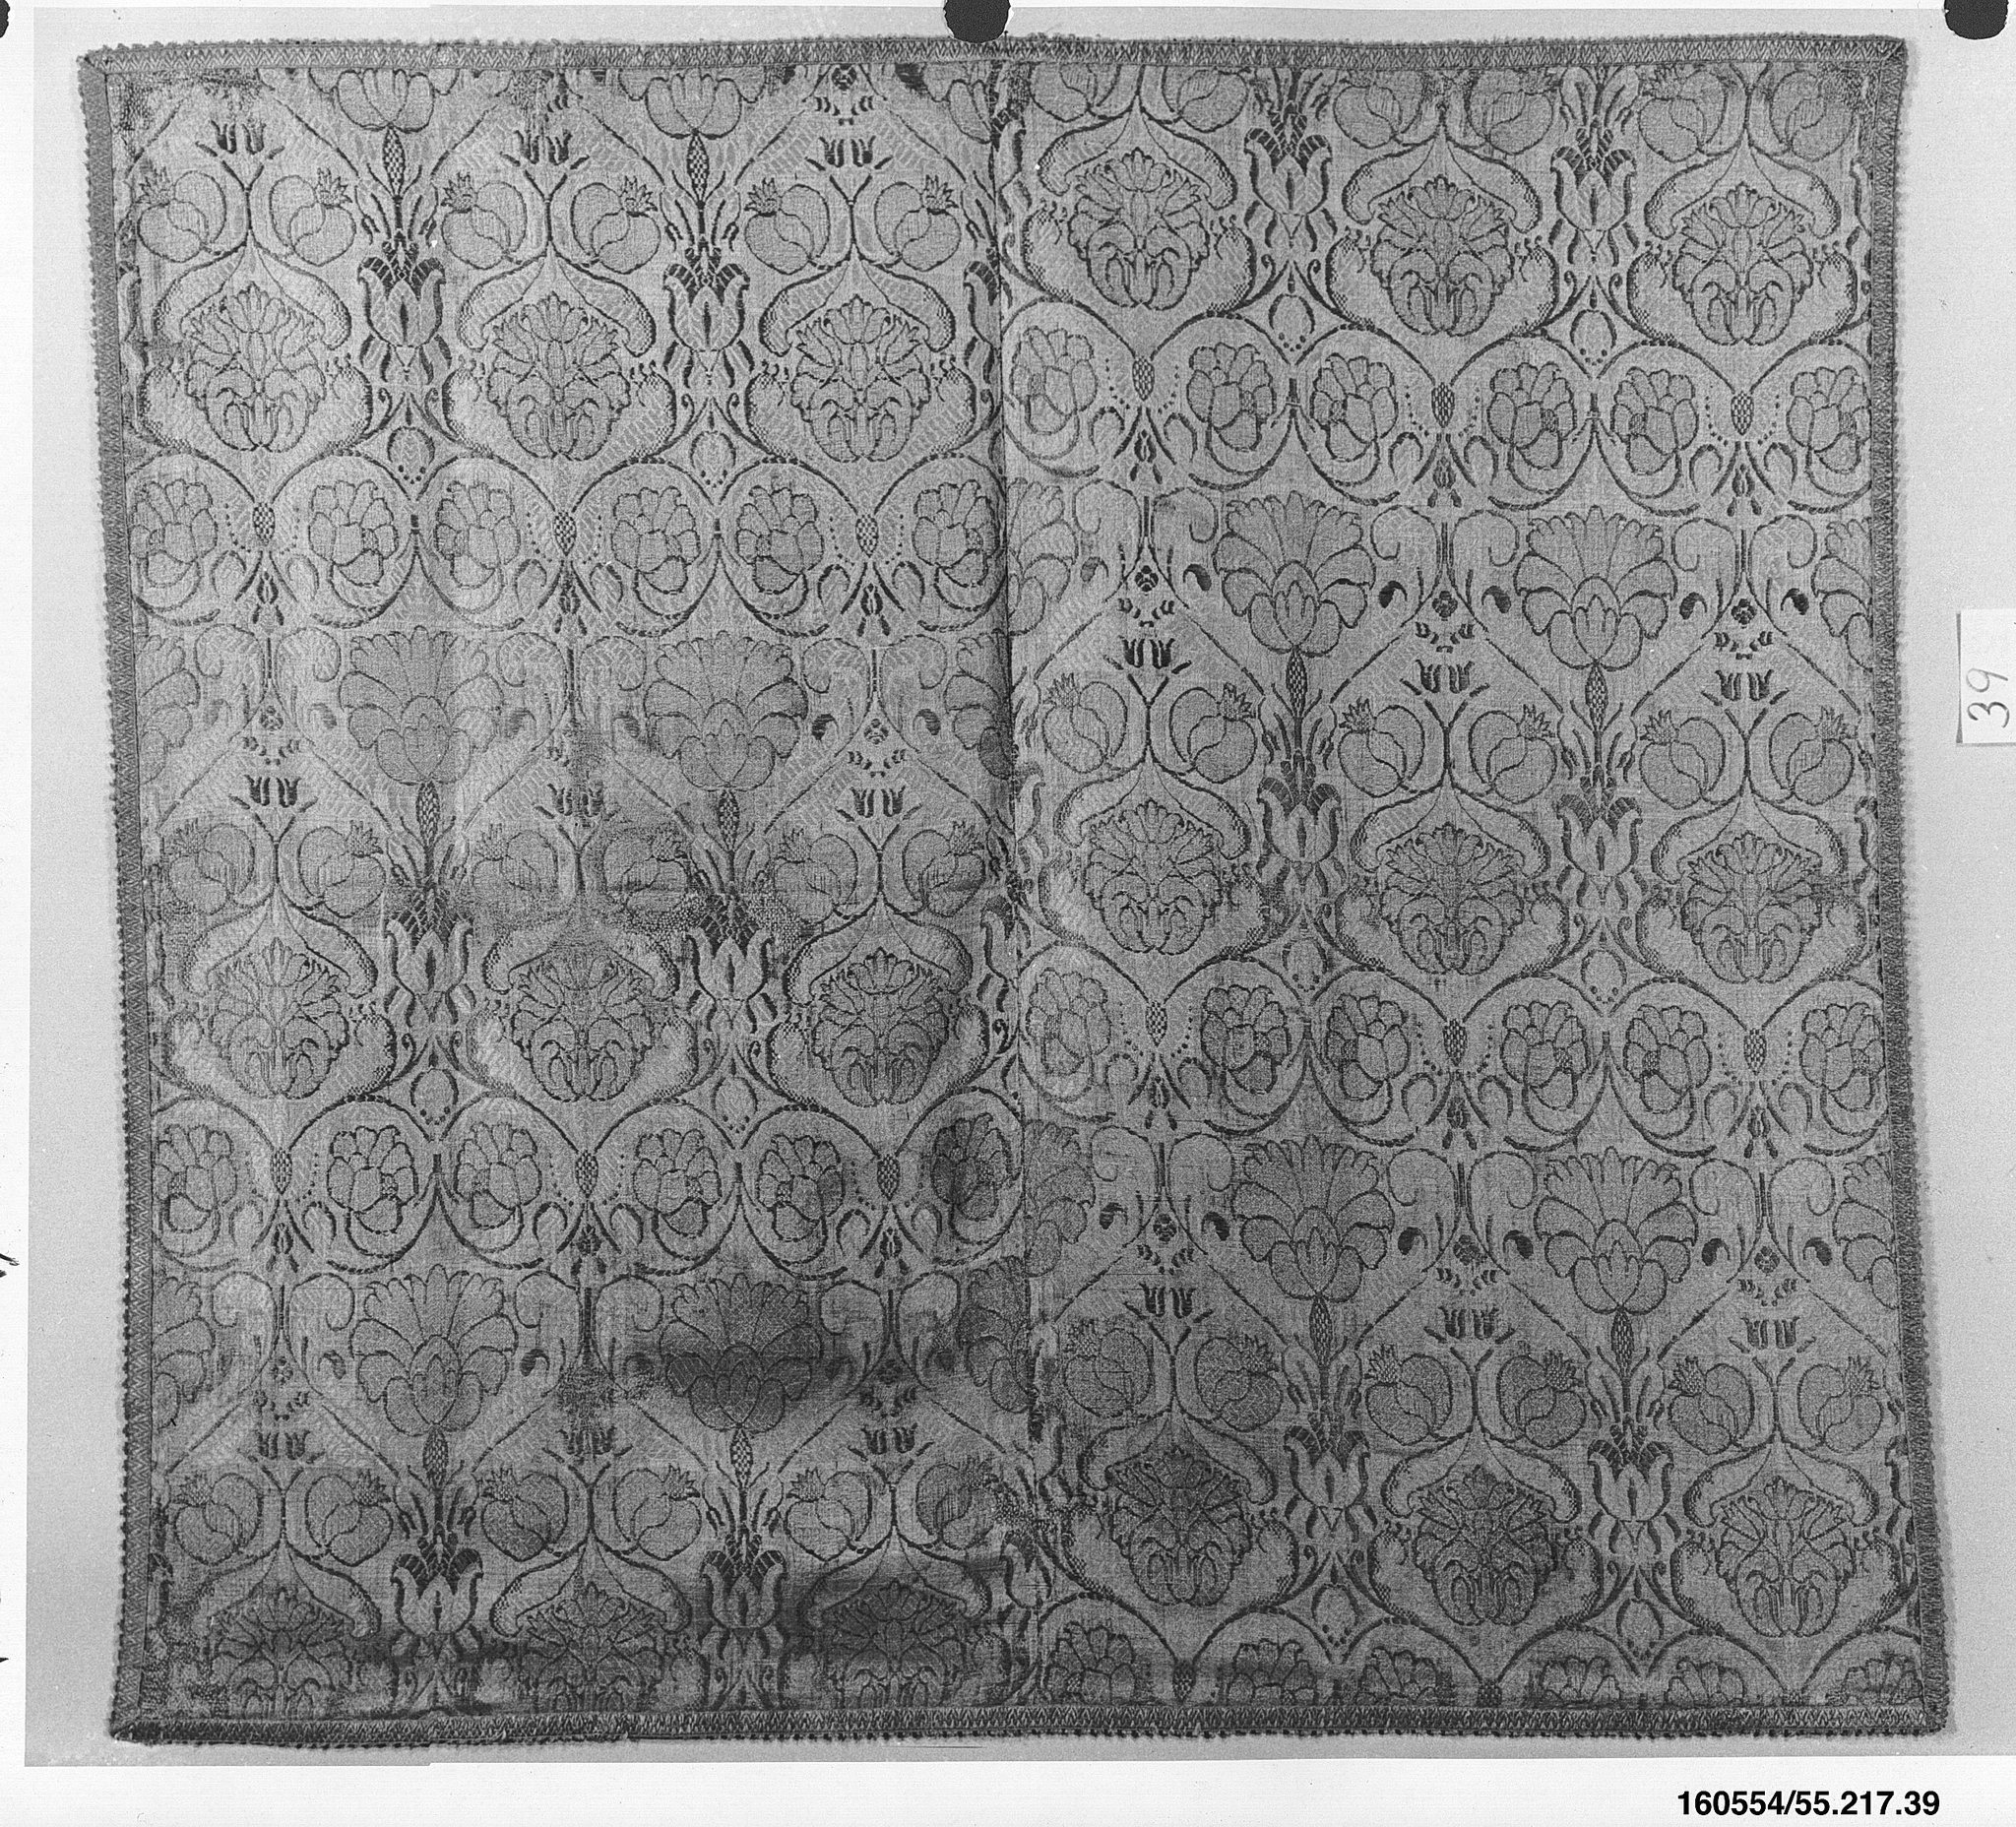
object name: piece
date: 1601-1700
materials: metal thread, silk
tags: flowers